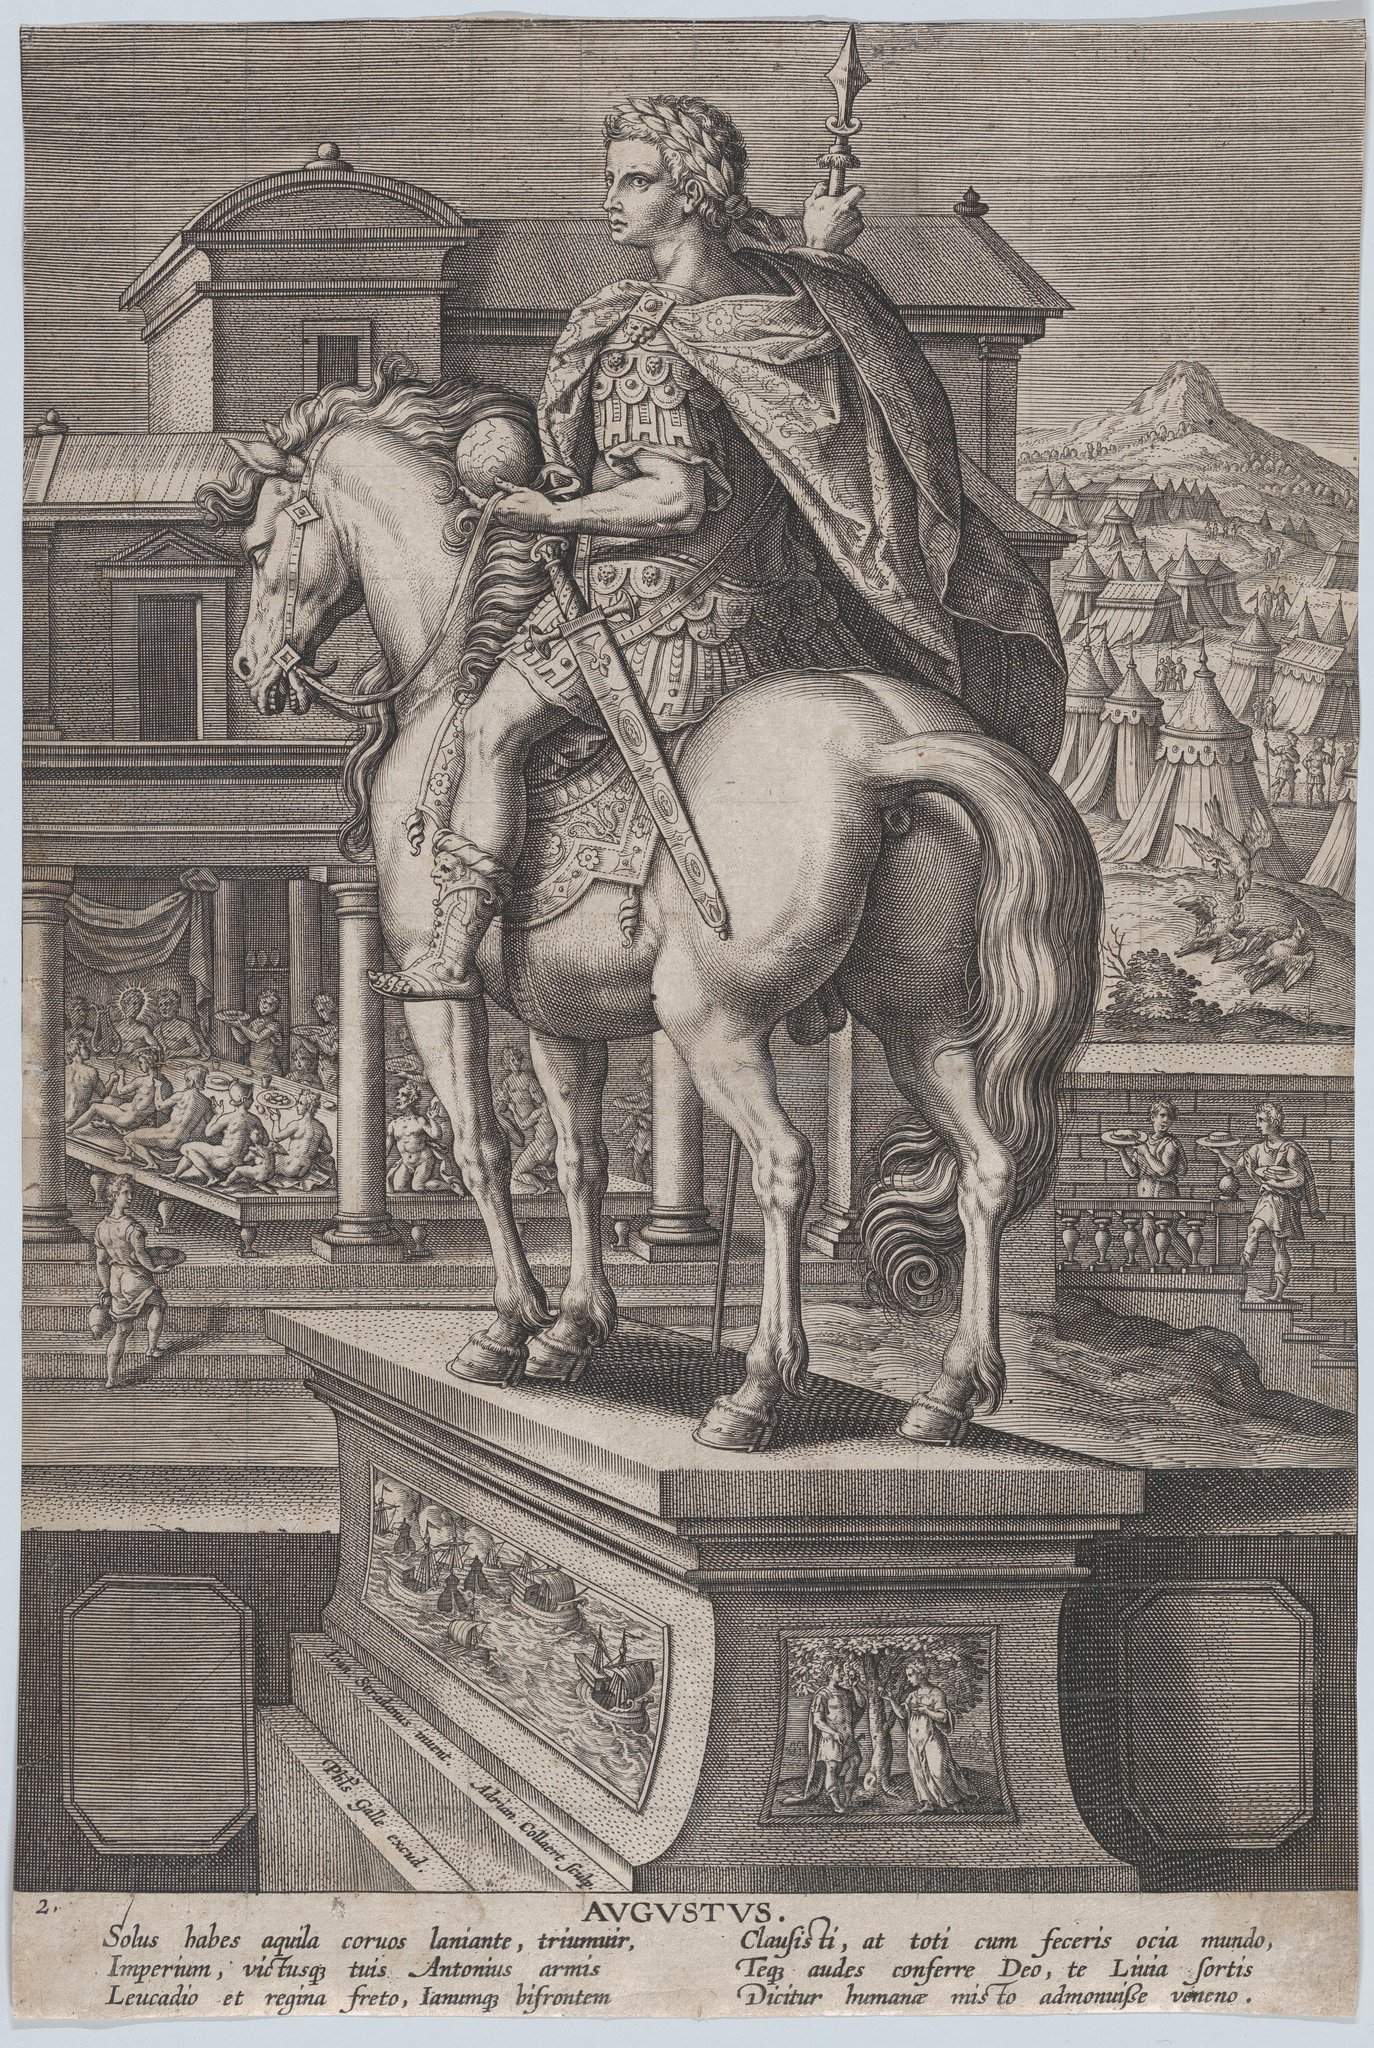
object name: print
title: Plate 2: equestrian statue of Augustus, holding a globe and seen from behind, with a feast occurring at left in the background, from 'Roman Emperors on Horseback'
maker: adriaen collaert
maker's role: artist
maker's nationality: netherlandish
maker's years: 1560-1618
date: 1587-1589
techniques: engraving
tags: sculpture,emperor augustus,horses